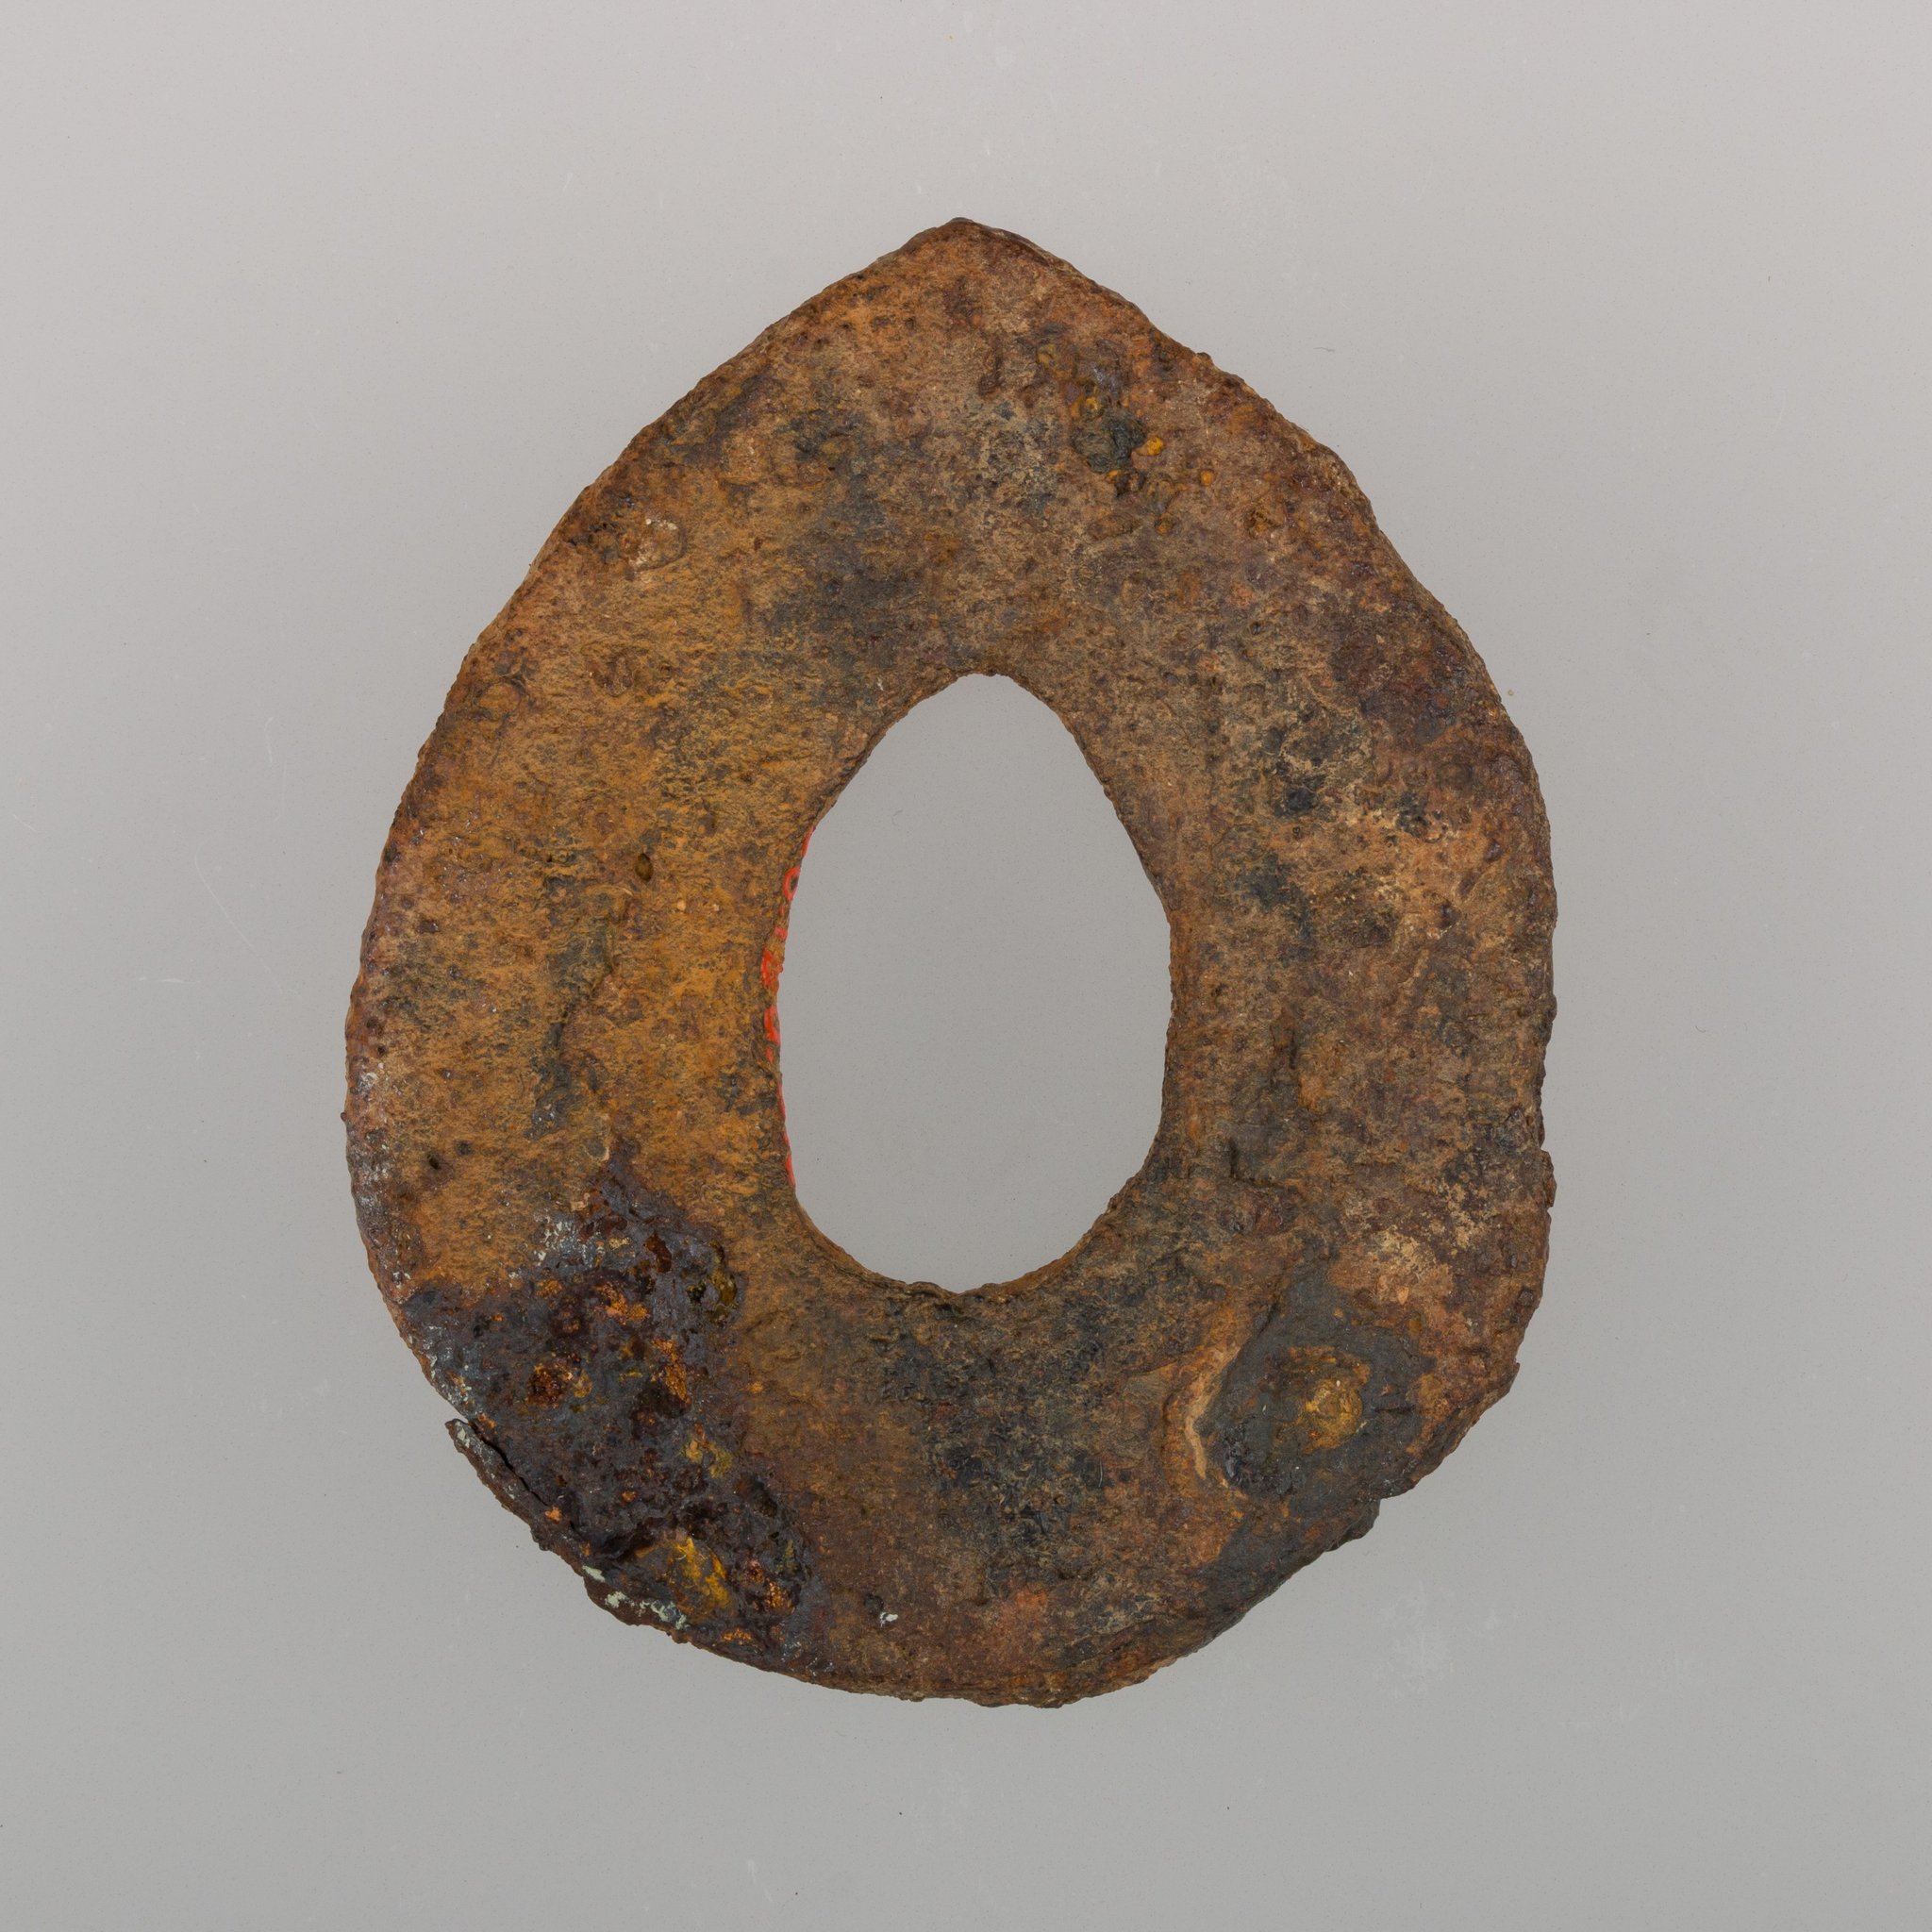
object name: sword guard tsuba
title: Sword Guard (Tsuba)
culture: japanese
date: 201-300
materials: iron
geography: japan